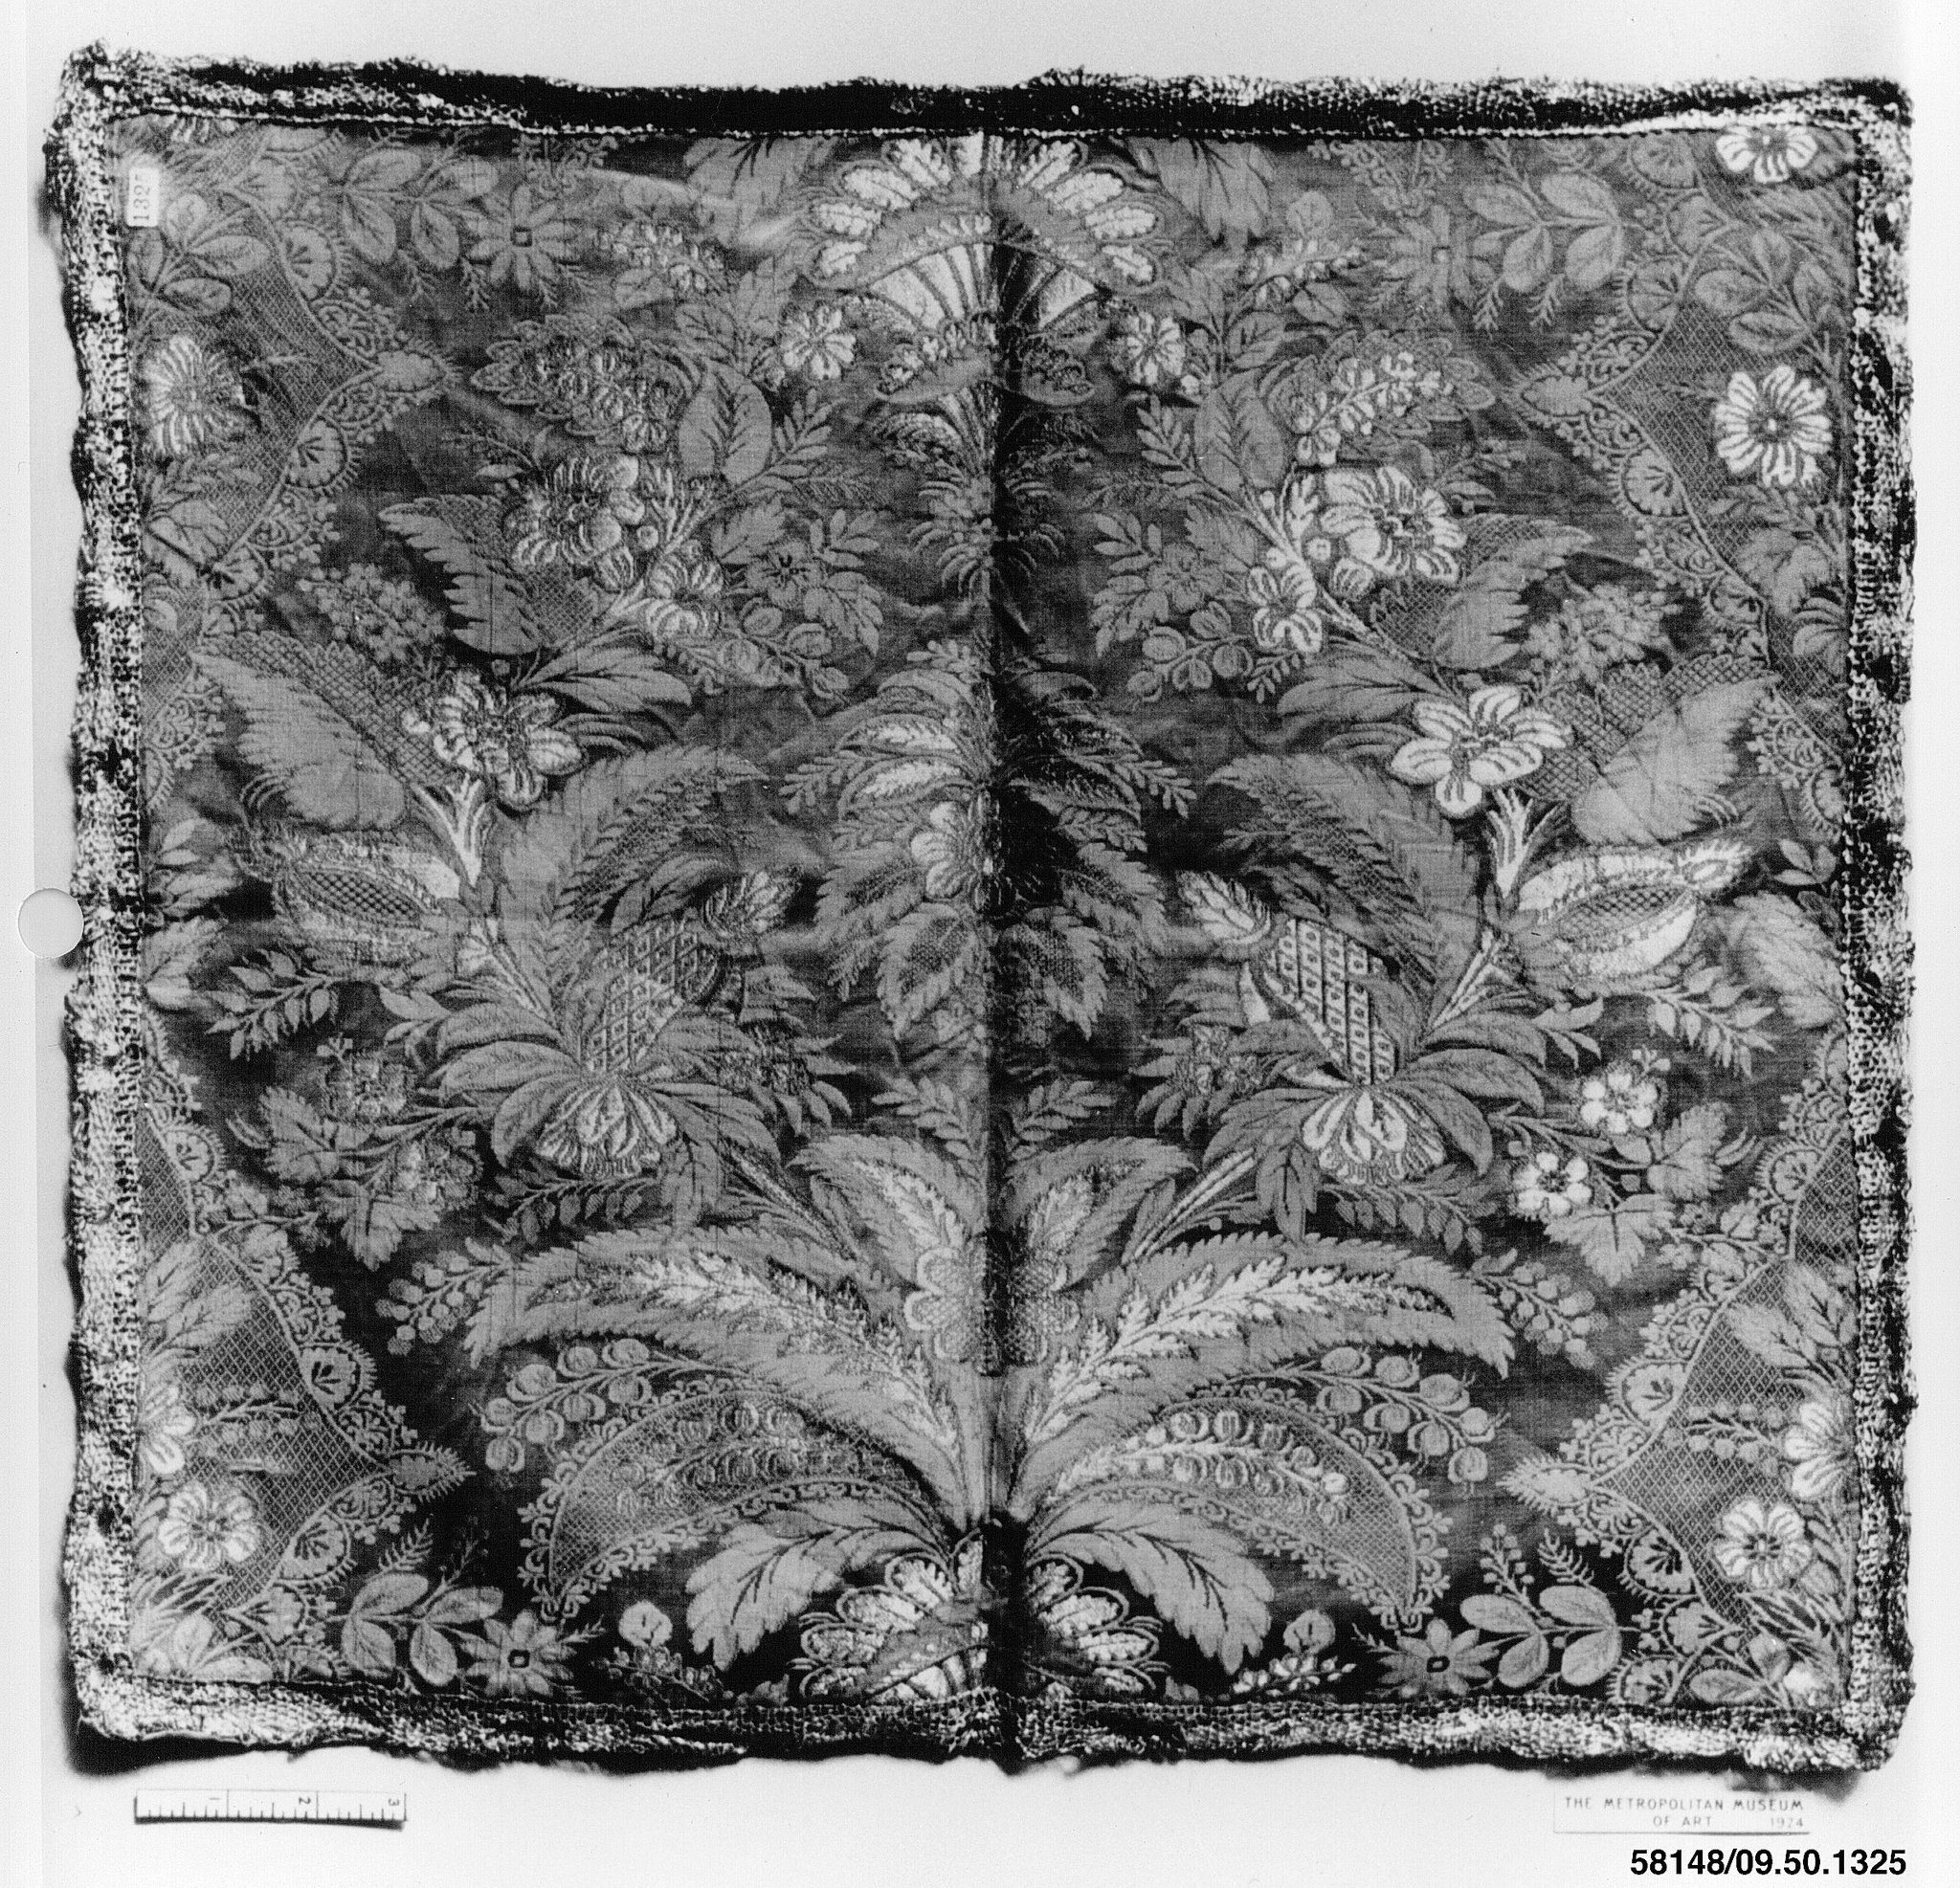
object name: piece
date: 1725-1730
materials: metal thread, silk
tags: flowers,leaves